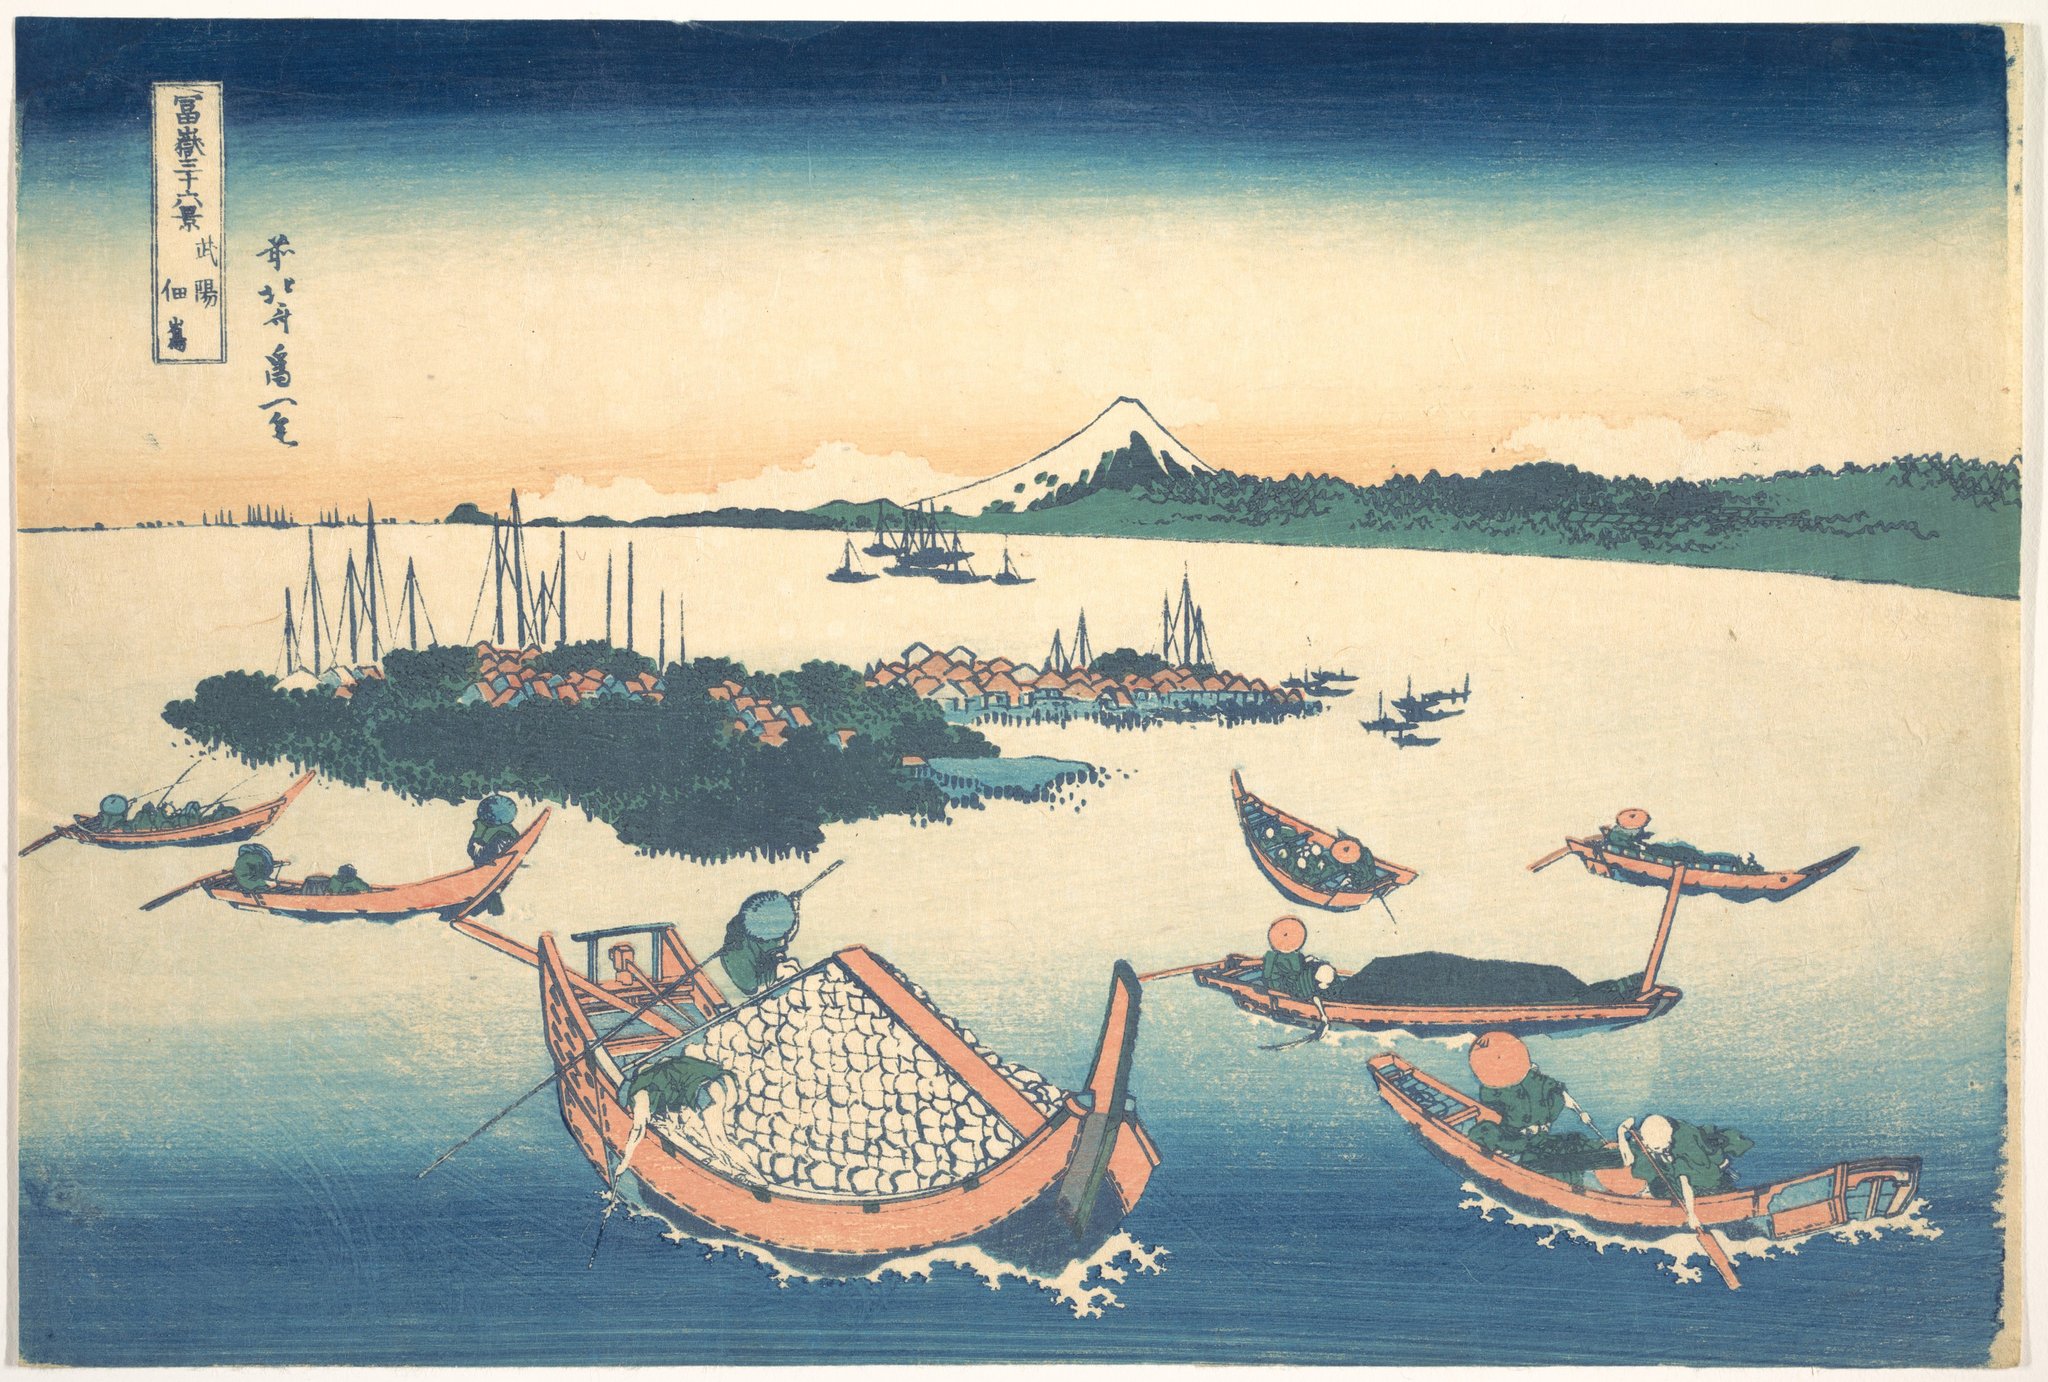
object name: woodblock print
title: Tsukudajima in Musashi Province (Buyō Tsukudajima), from the series Thirty-six Views of Mount Fuji (Fugaku sanjūrokkei)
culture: japanese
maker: katsushika hokusai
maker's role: artist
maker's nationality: japanese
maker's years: 1760-1849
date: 1830-1832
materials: ink, paper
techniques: woodblock print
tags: mountains,boats,islands